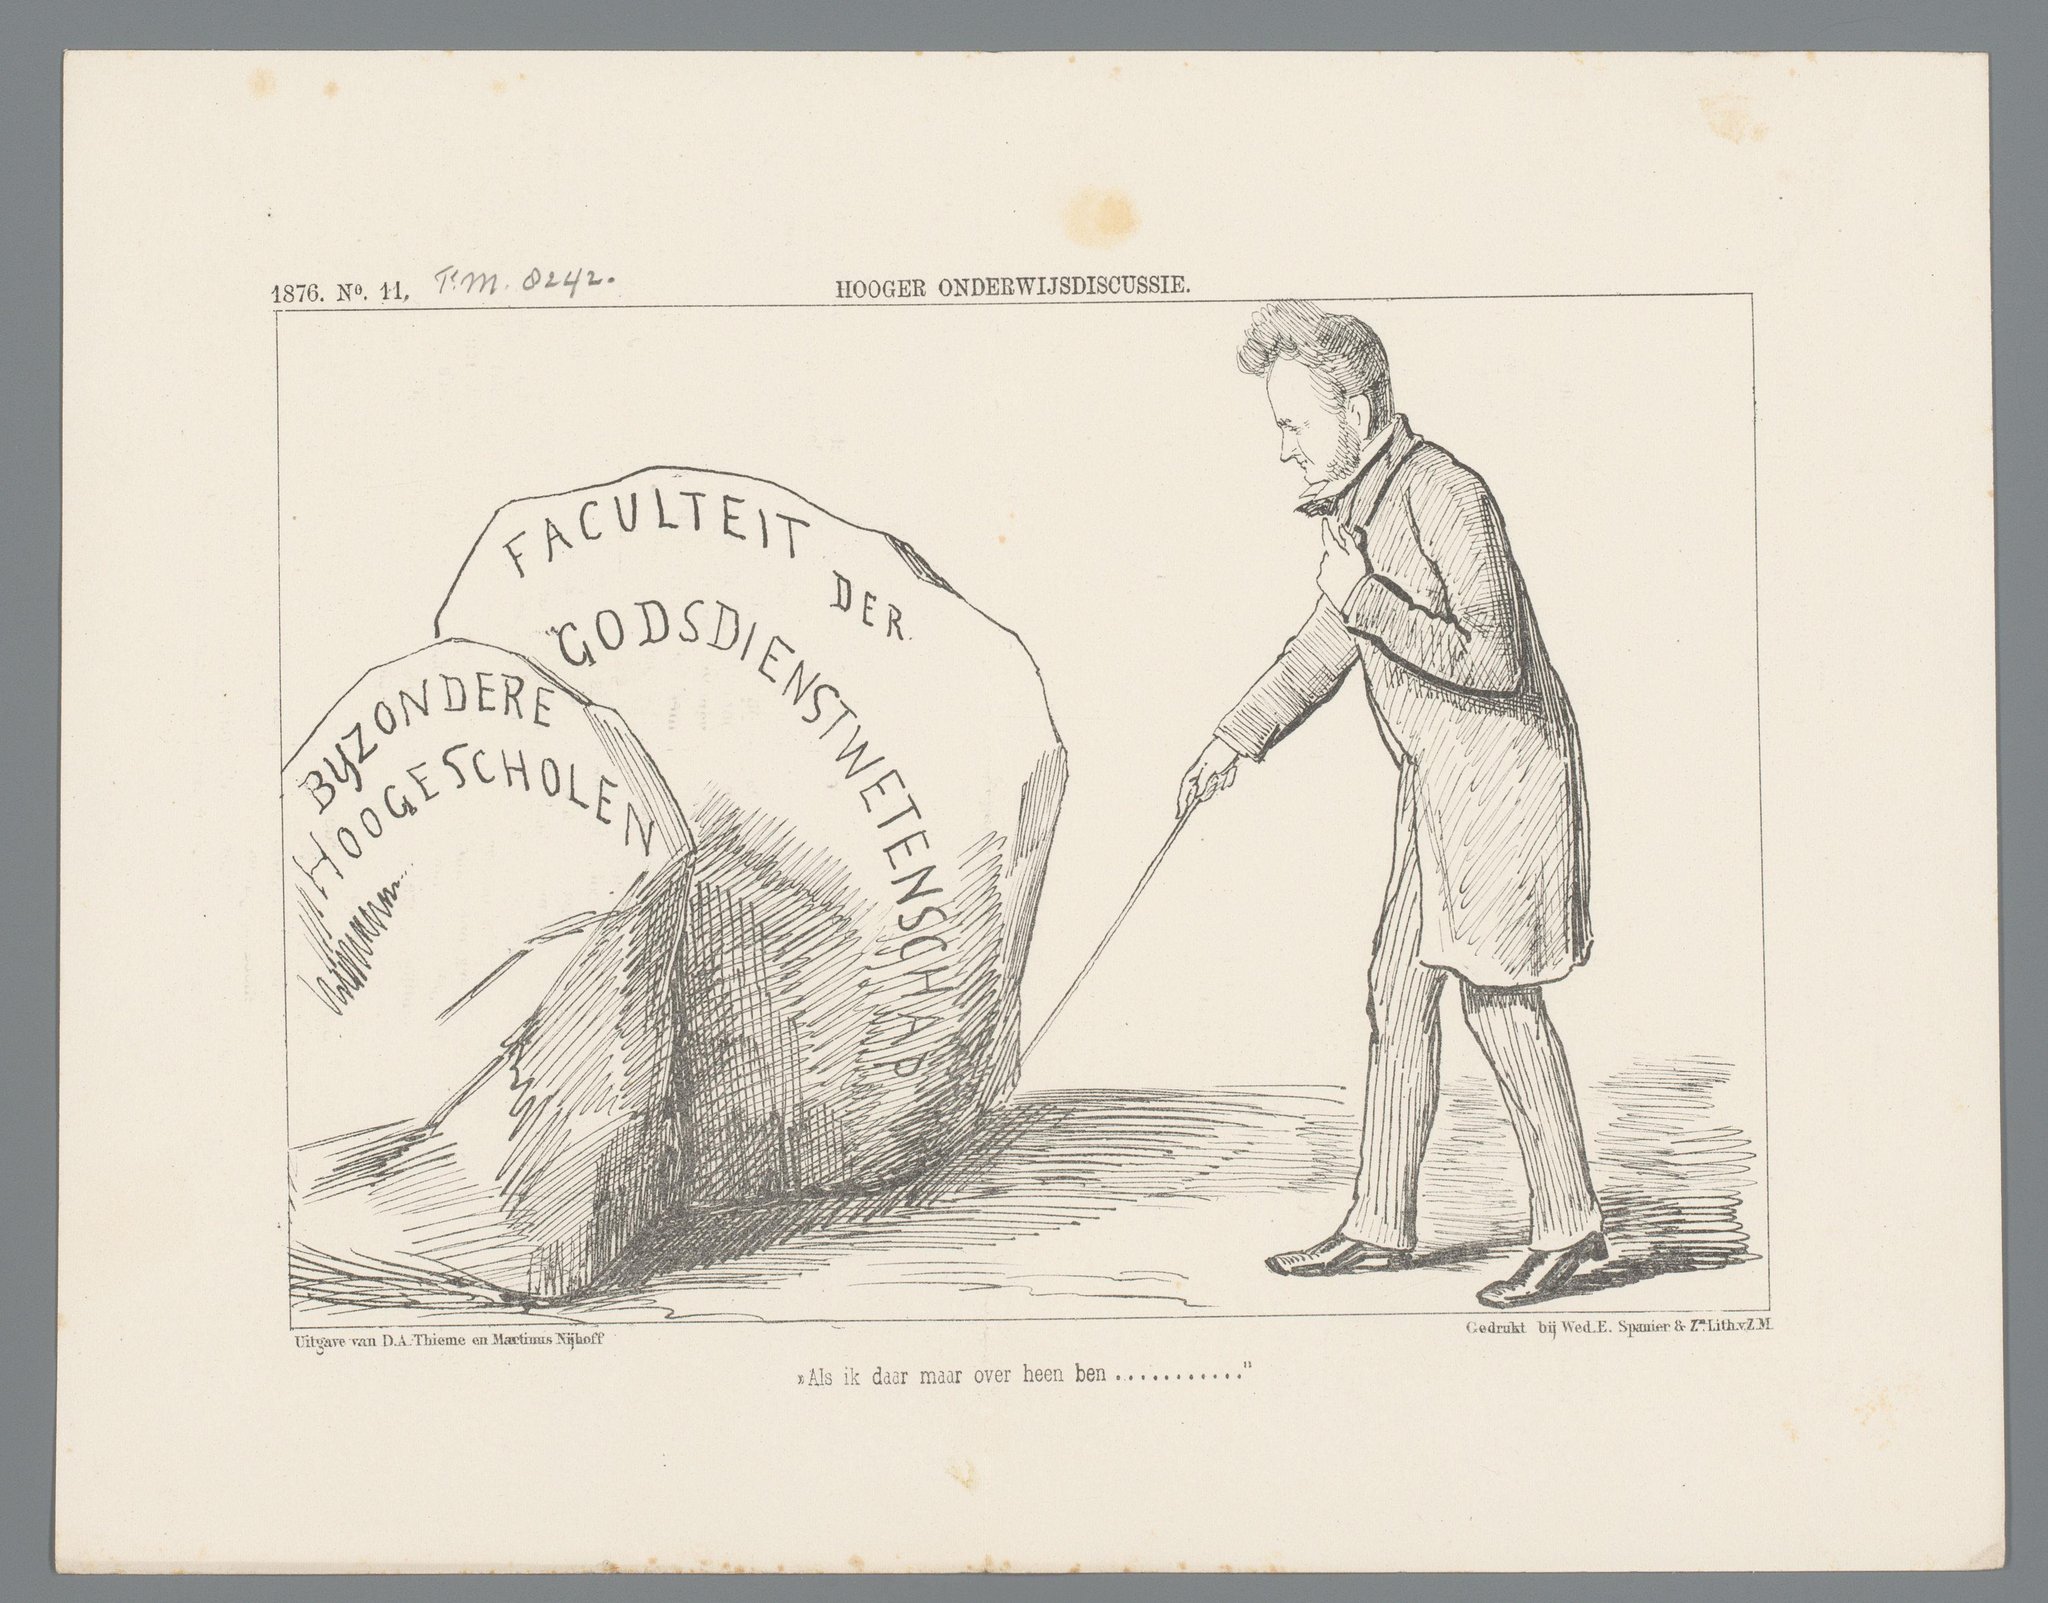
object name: cartoon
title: Hooger onderwijsdiscussie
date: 1876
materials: paper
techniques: lithograph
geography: the hague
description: Spotprent . Plaat verschenen bij het weekblad De Nederlandsche Spectator, nr. 11, 1876.